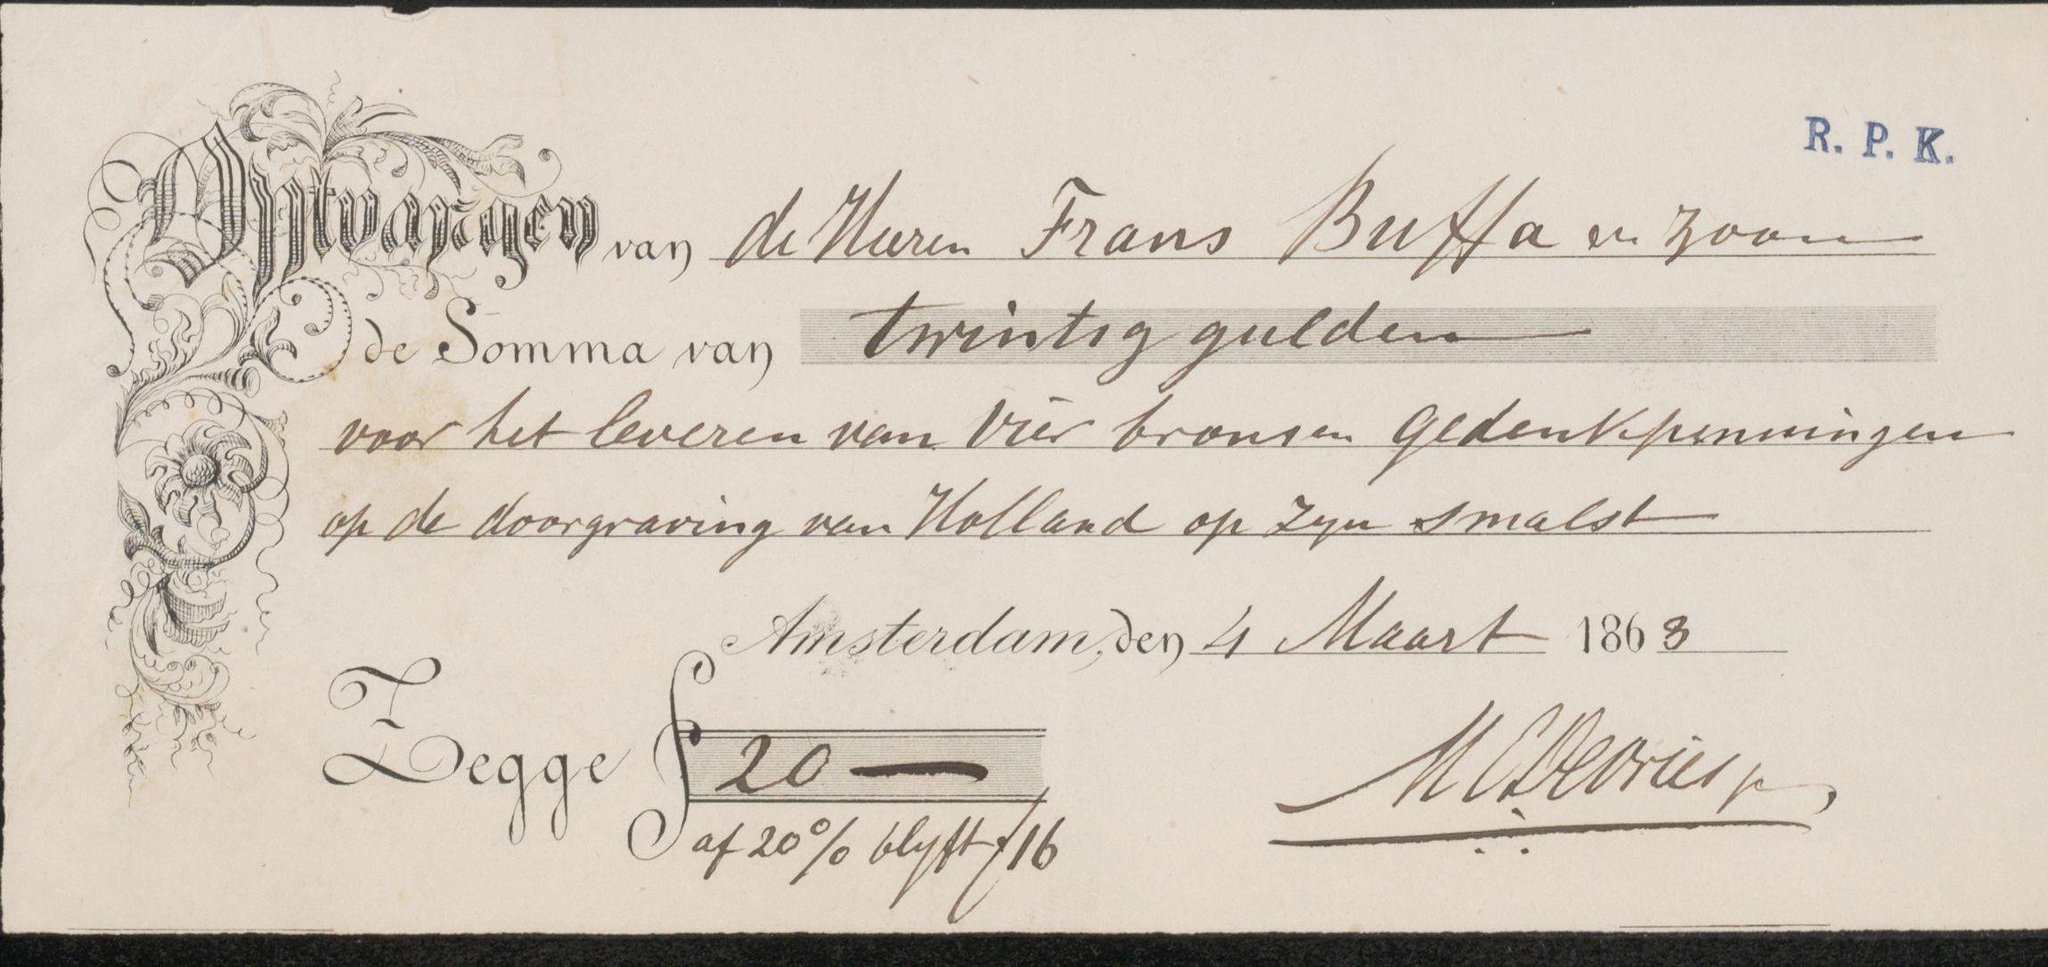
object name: ontvangstbewijs, kwitantie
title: Kwitantie voor Moses de Vries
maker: moses cohen de vries junior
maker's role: diamantslijper, graveur, medailleur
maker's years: 1807-1883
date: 1868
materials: ink, paper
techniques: pen, printing, writing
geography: amsterdam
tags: applied arts, arts and crafts; industrial design, money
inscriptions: collector's mark: Lugt 2233